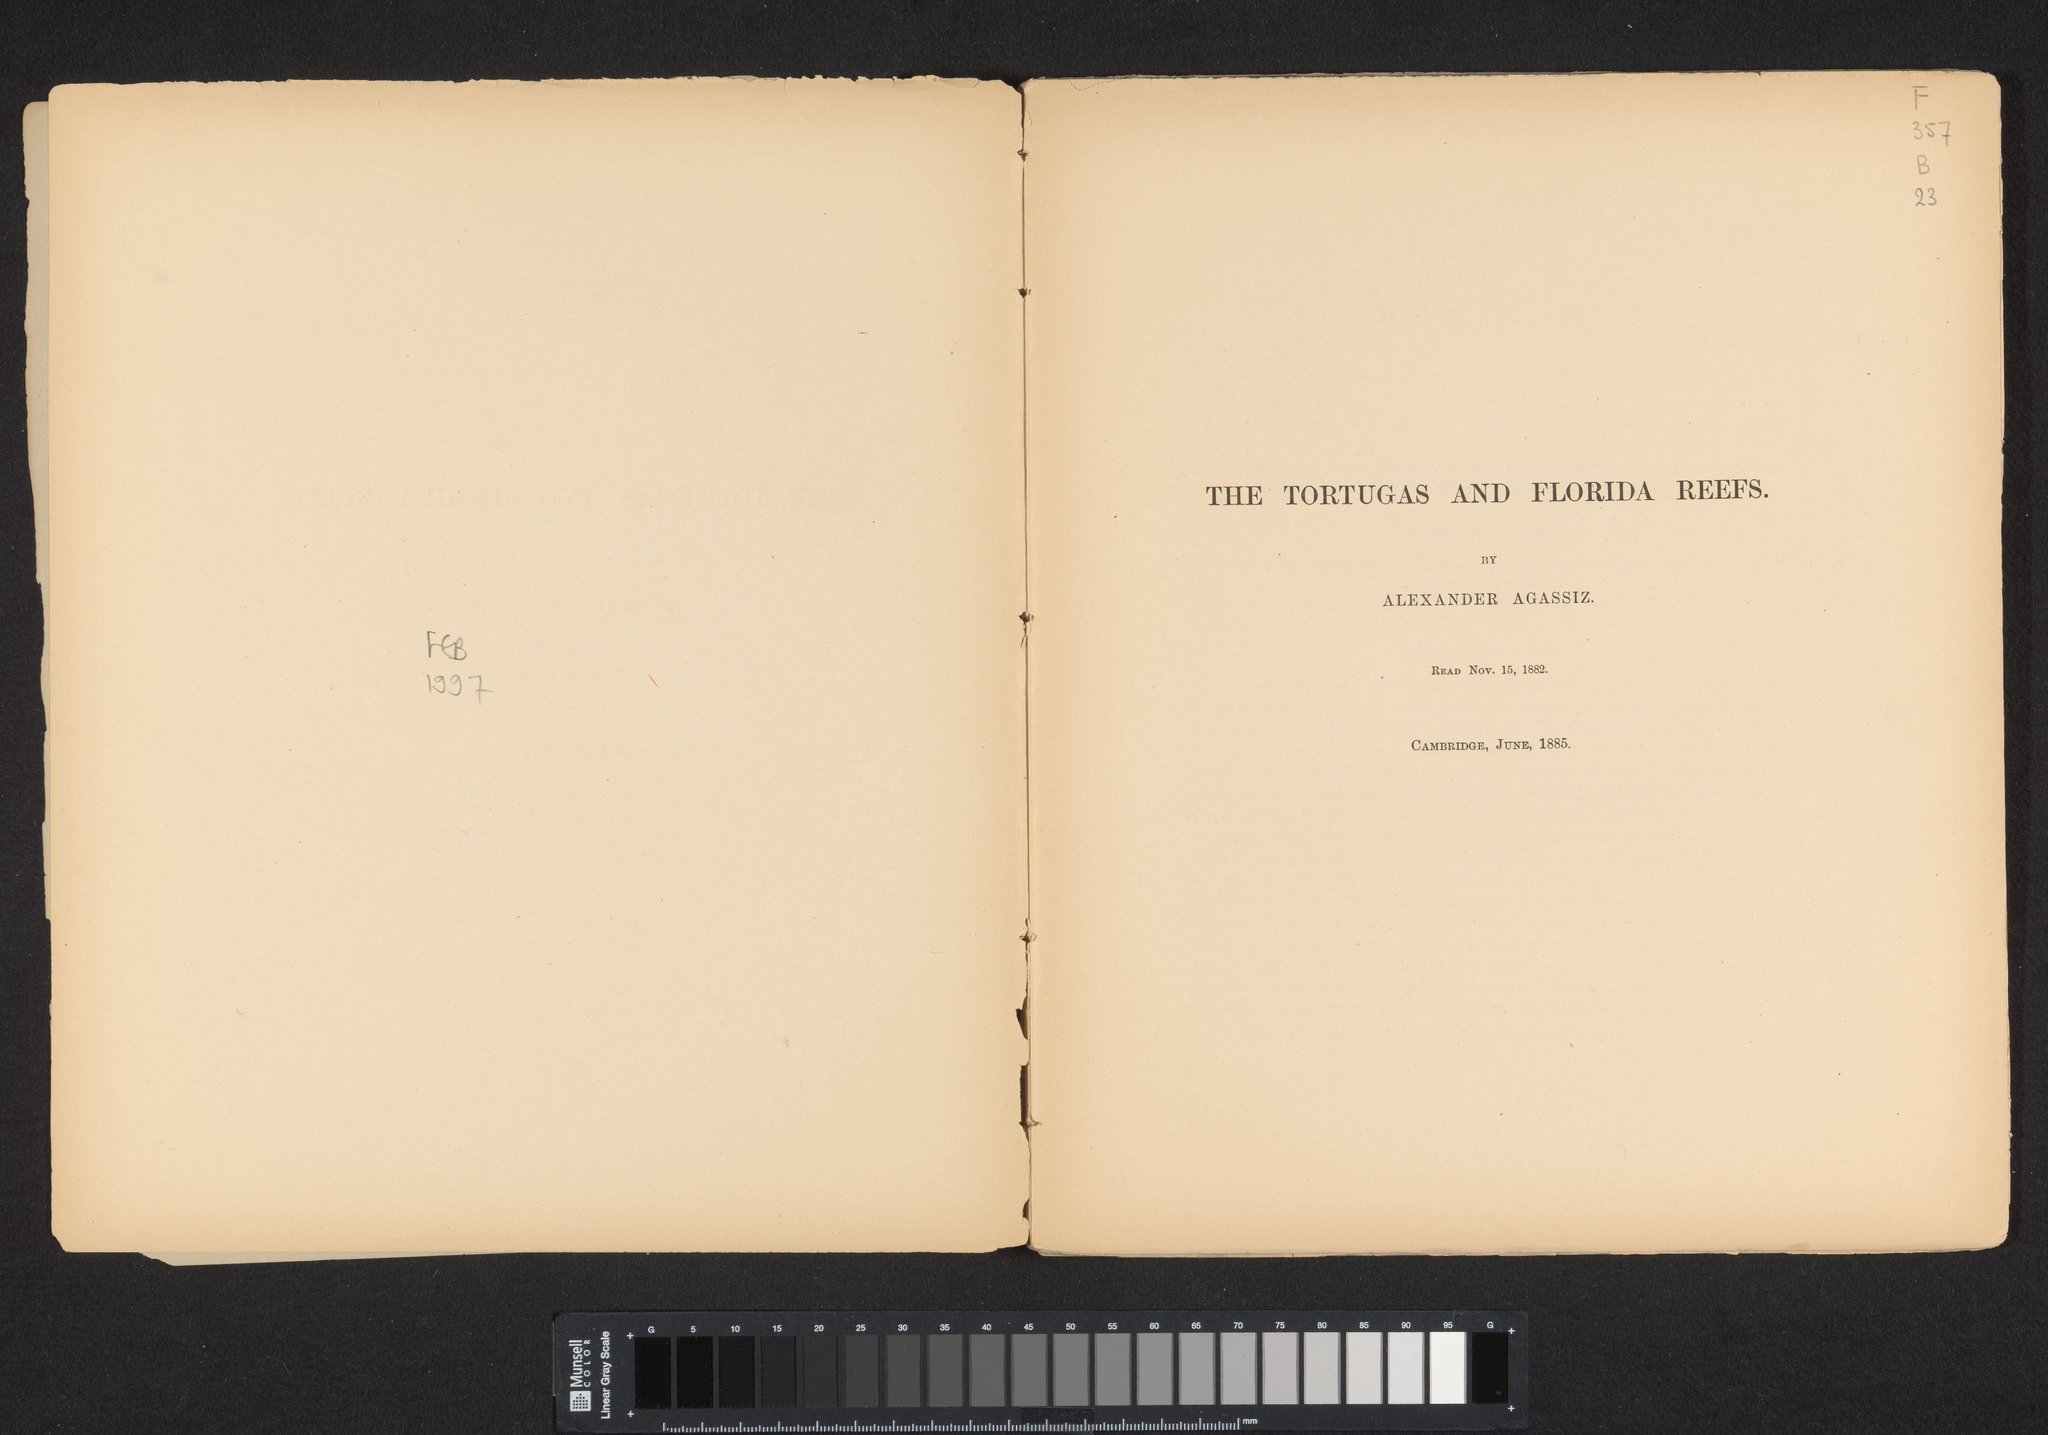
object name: book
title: The Tortugas and Florida reefs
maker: alexander agassiz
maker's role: engineer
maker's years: 1835-1910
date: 1885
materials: paper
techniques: photograph